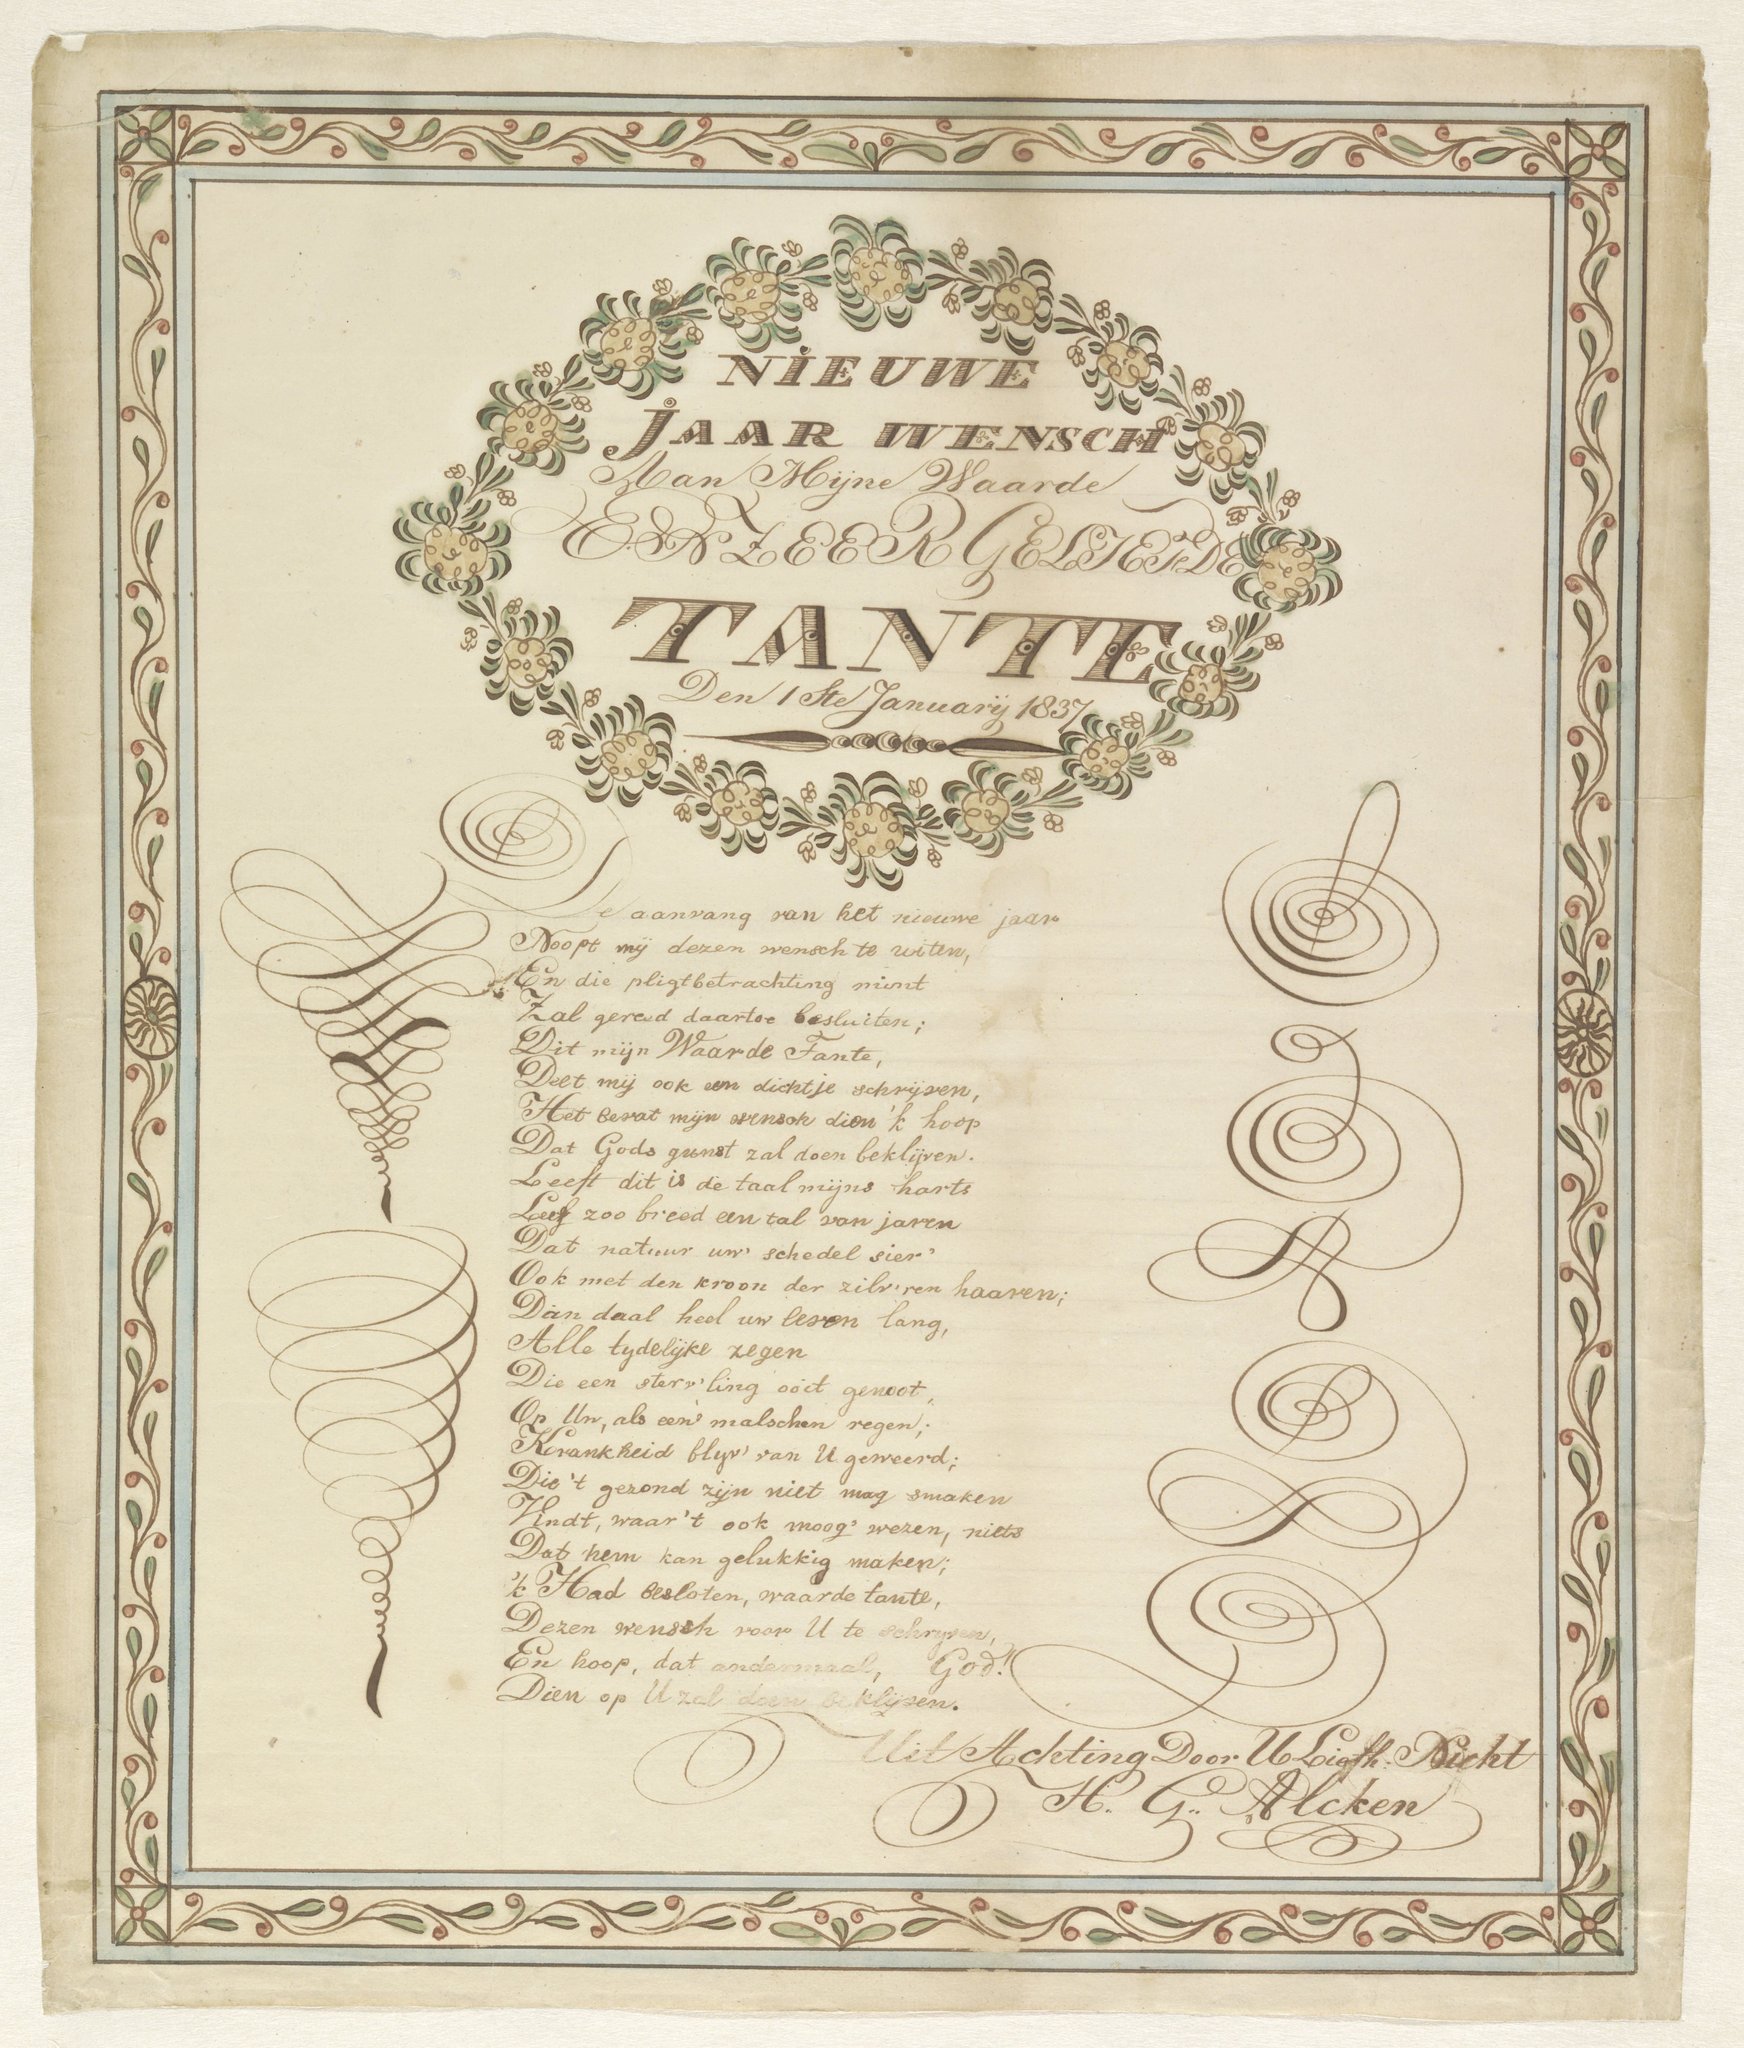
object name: wensbrief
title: Nieuwe / jaar wensch / Aan mijne waarde / en zeer geliefde / tante / den 1 ste januarij 1837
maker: h.g. alcken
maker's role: draughtsman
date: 1837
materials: paper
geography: netherlands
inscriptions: date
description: Nieuwjaarswens voor een tante, op 1 januari 1837. 24 regels Nederlands vers. Geheel omgeven door een sierlijst. Ondertekend door H.G. Alcken.